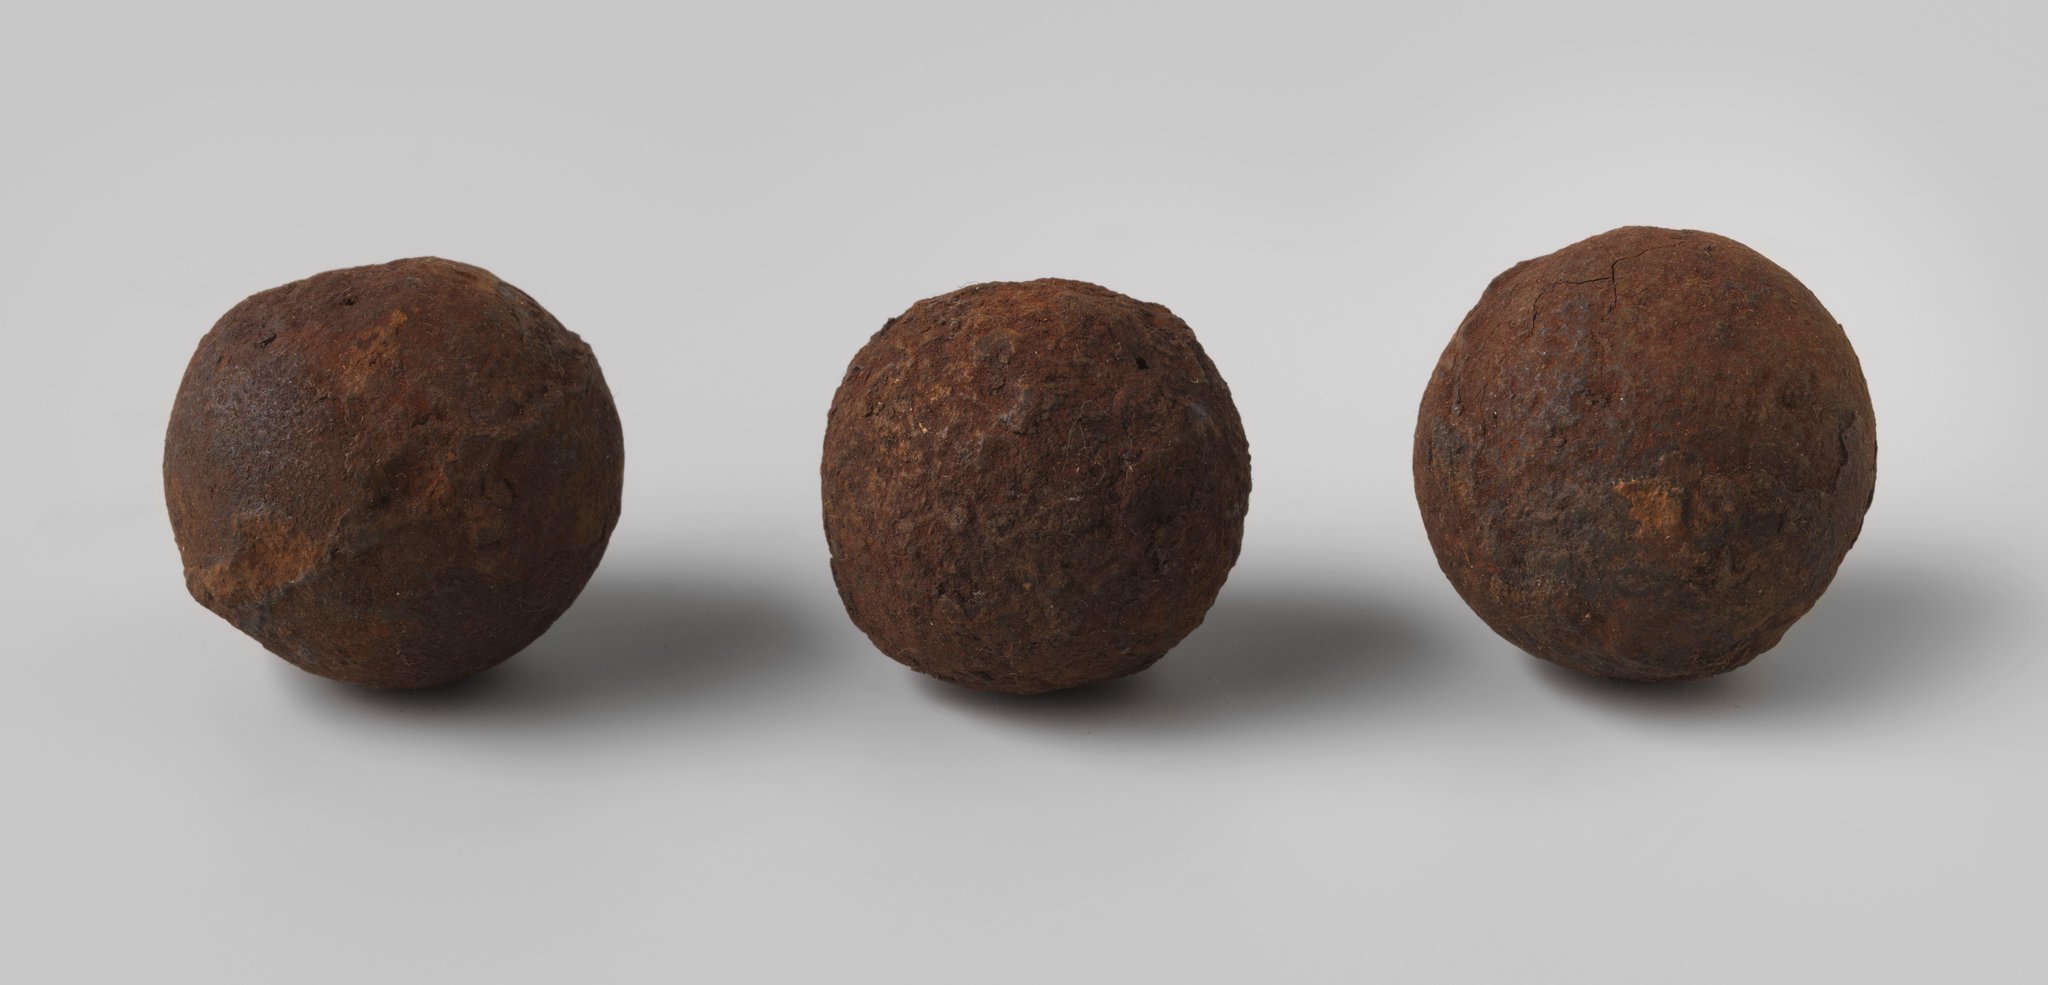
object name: bullet ammunition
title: Kogels uit het wrak van de Oost-Indiëvaarder Hollandia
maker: Anonymous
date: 1700-1743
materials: iron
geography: netherlands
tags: verenigde oostindische compagnie, hollandia (schip), annet